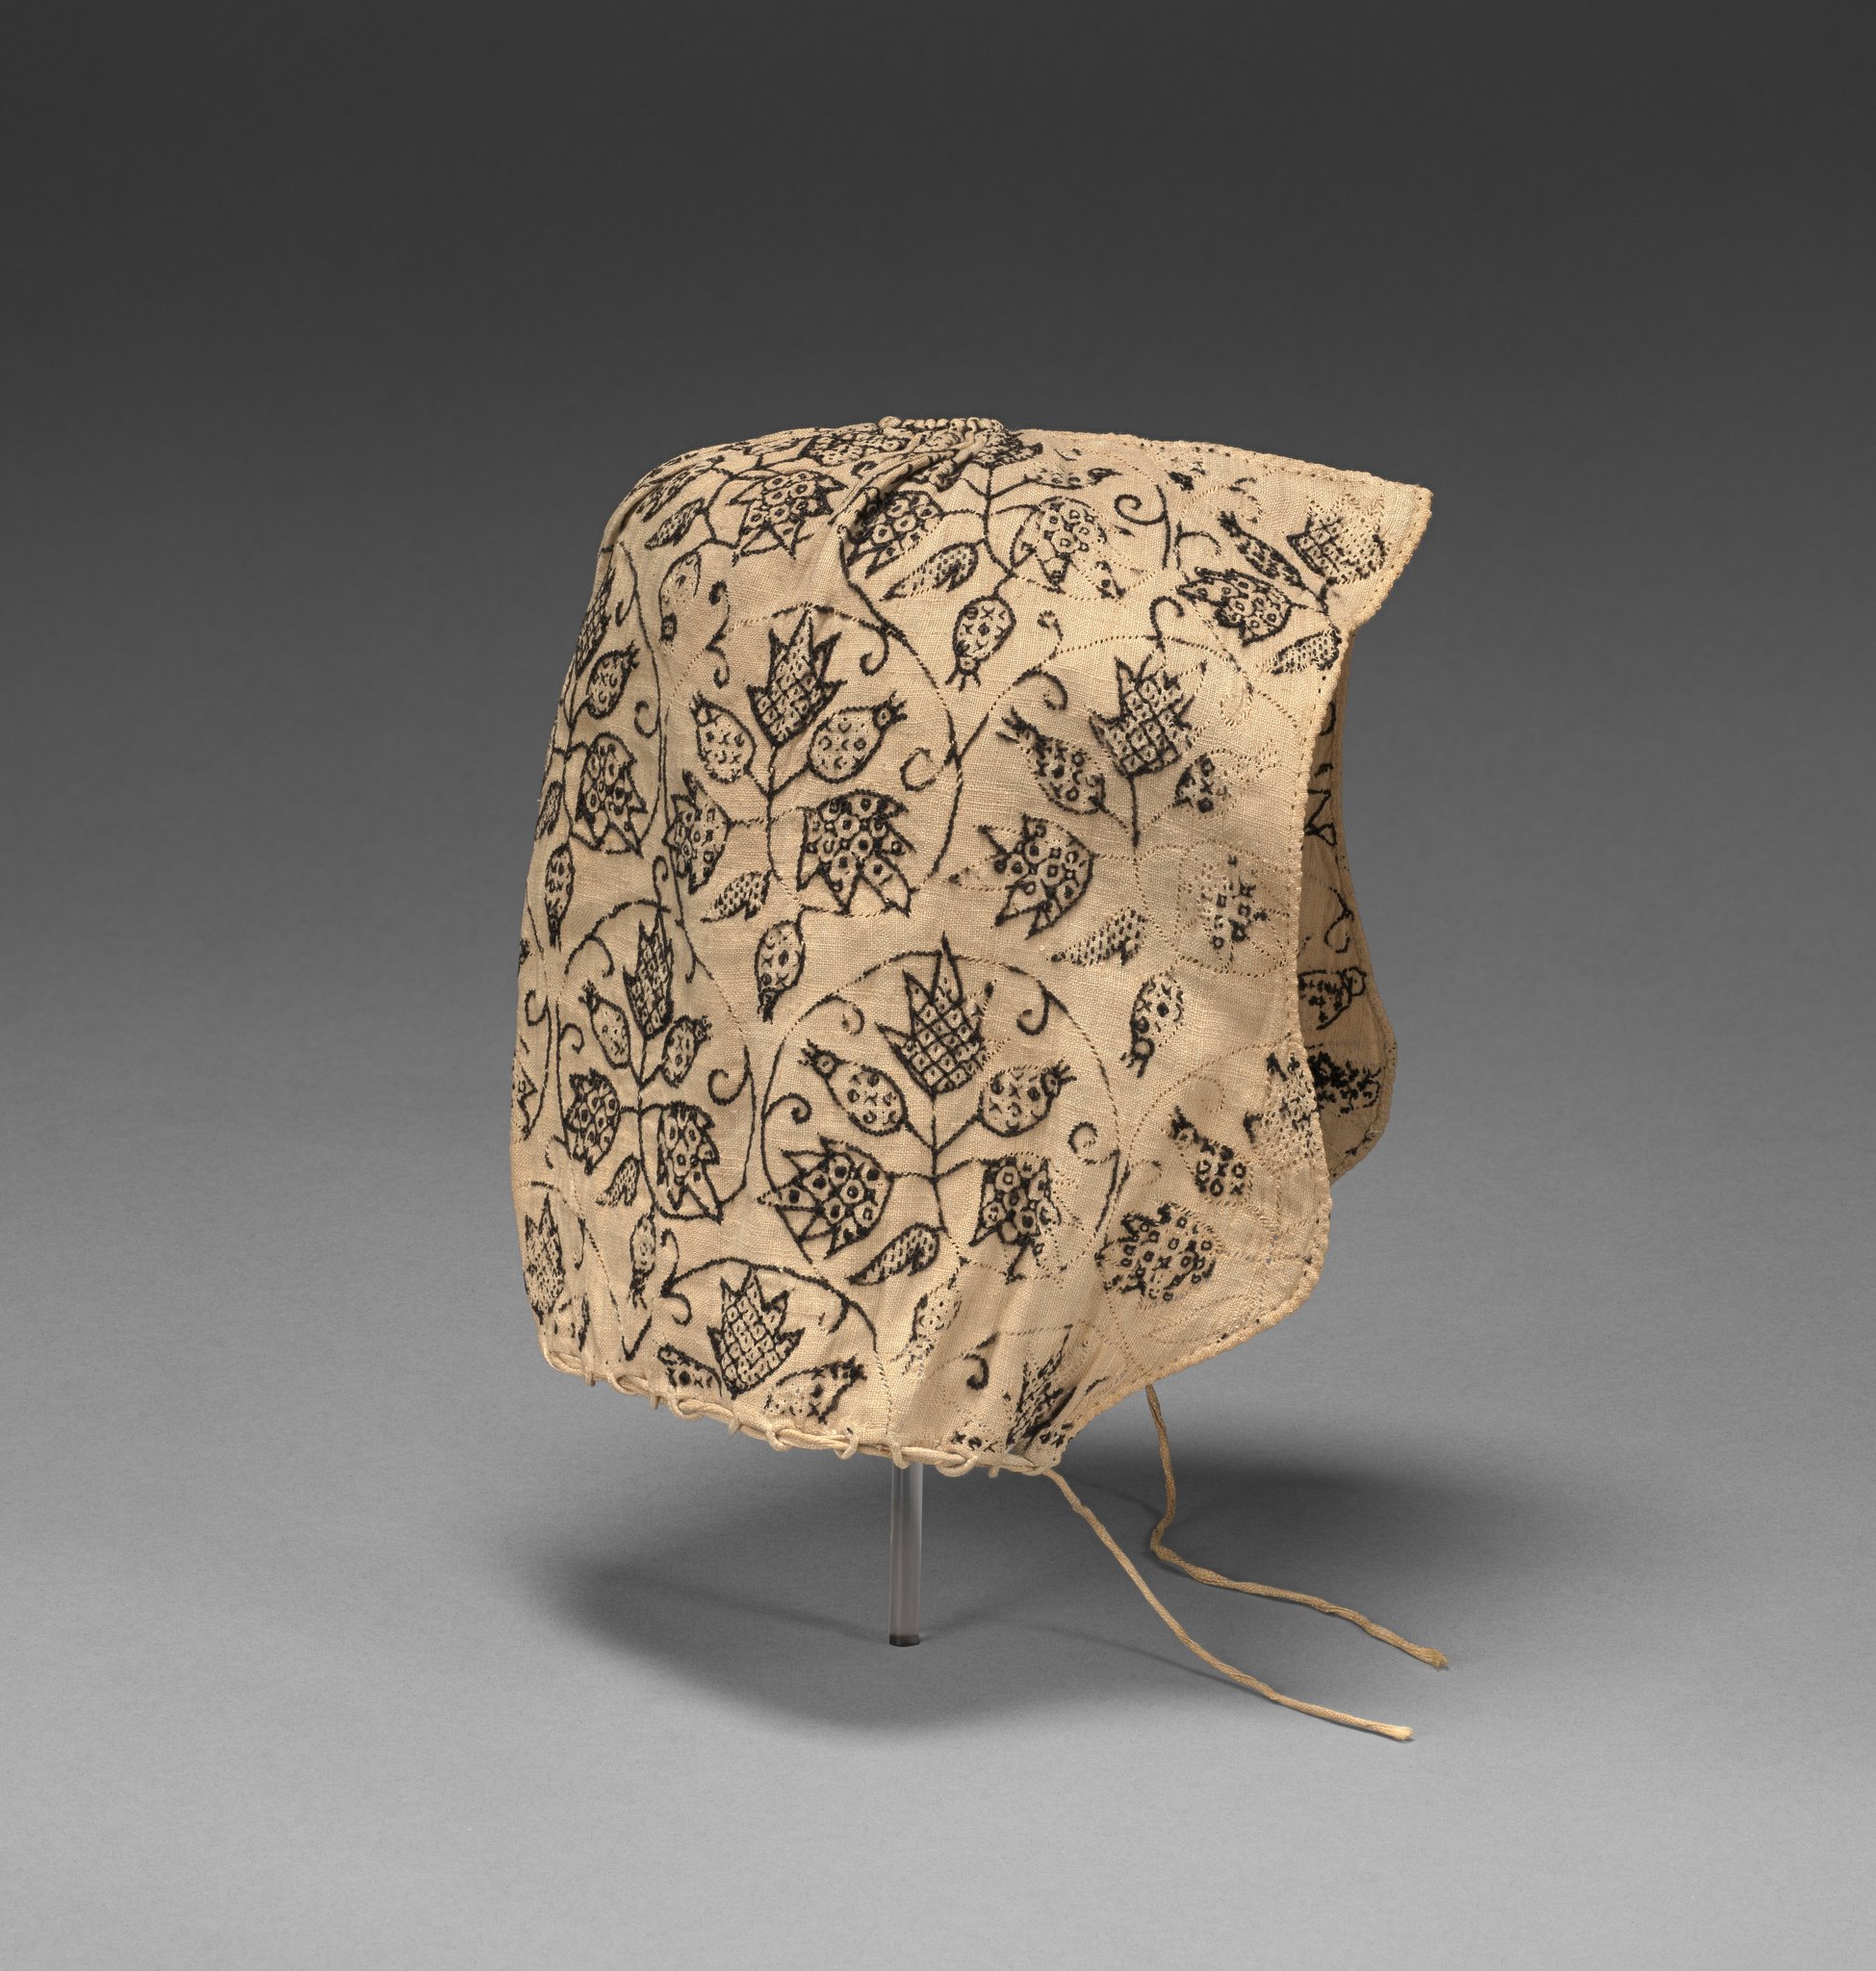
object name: coif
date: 1576-1600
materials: linen, silk